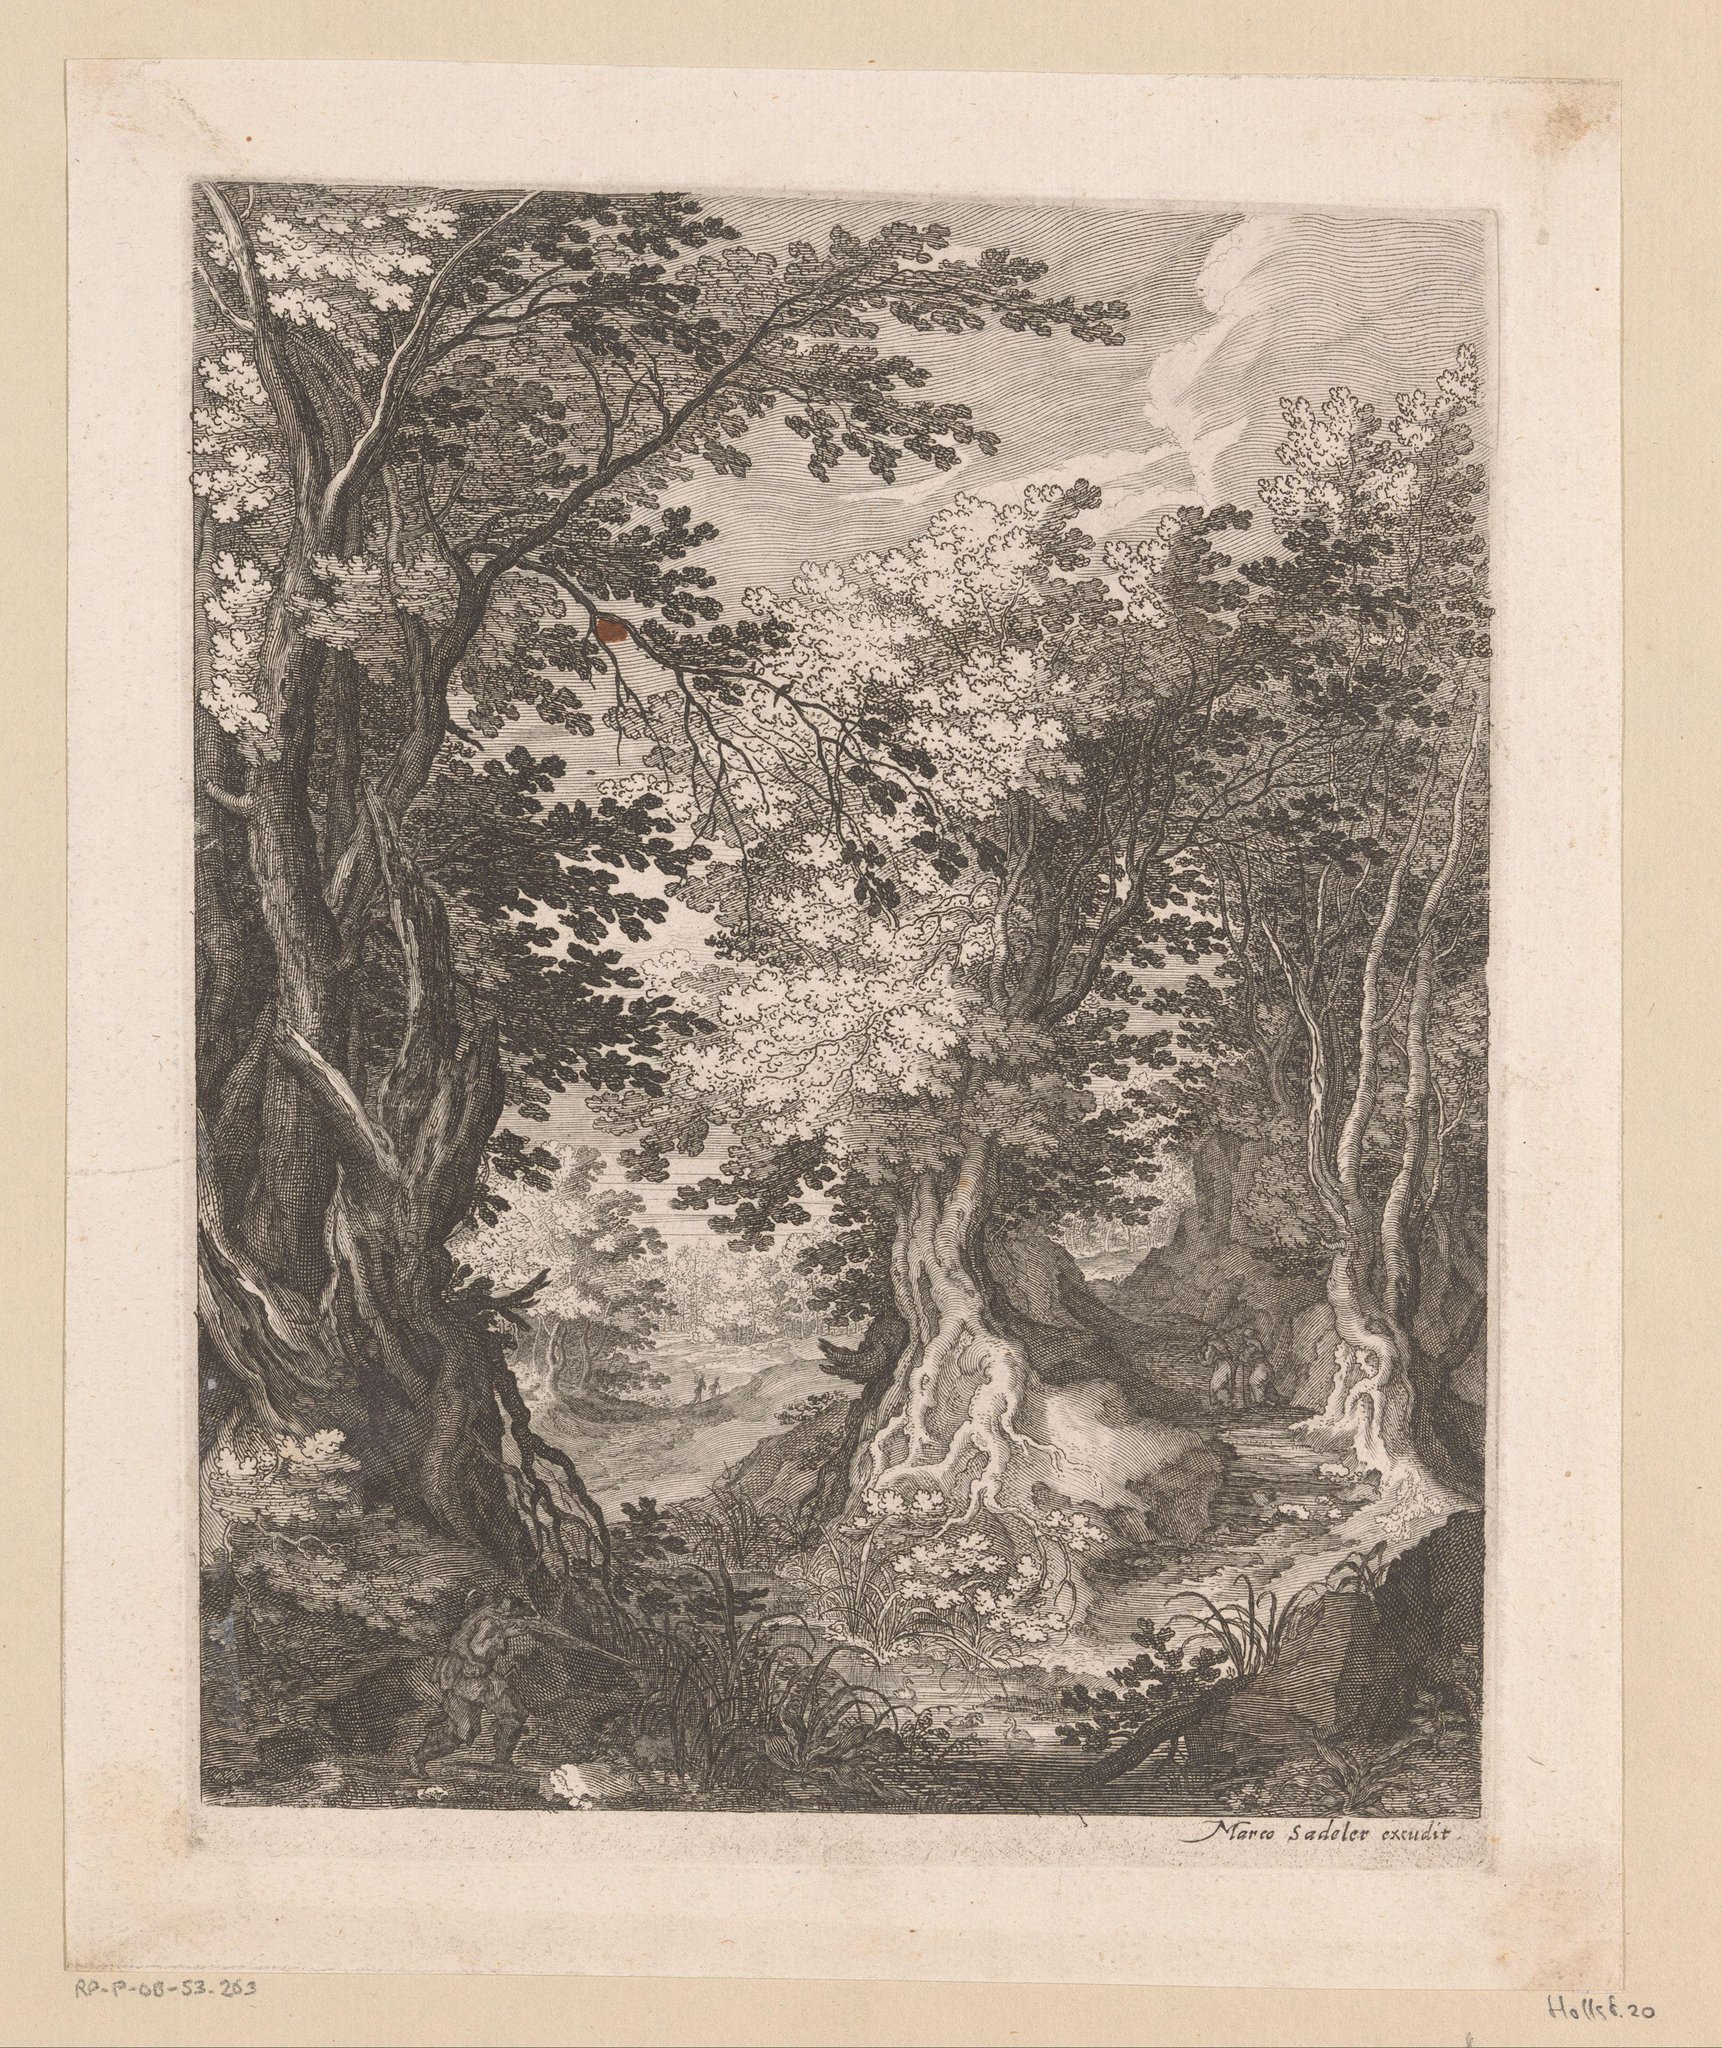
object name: print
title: Tien landschappen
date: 1586-1630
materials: paper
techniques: engraving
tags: forest path or lane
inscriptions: collector's mark: Lugt 240